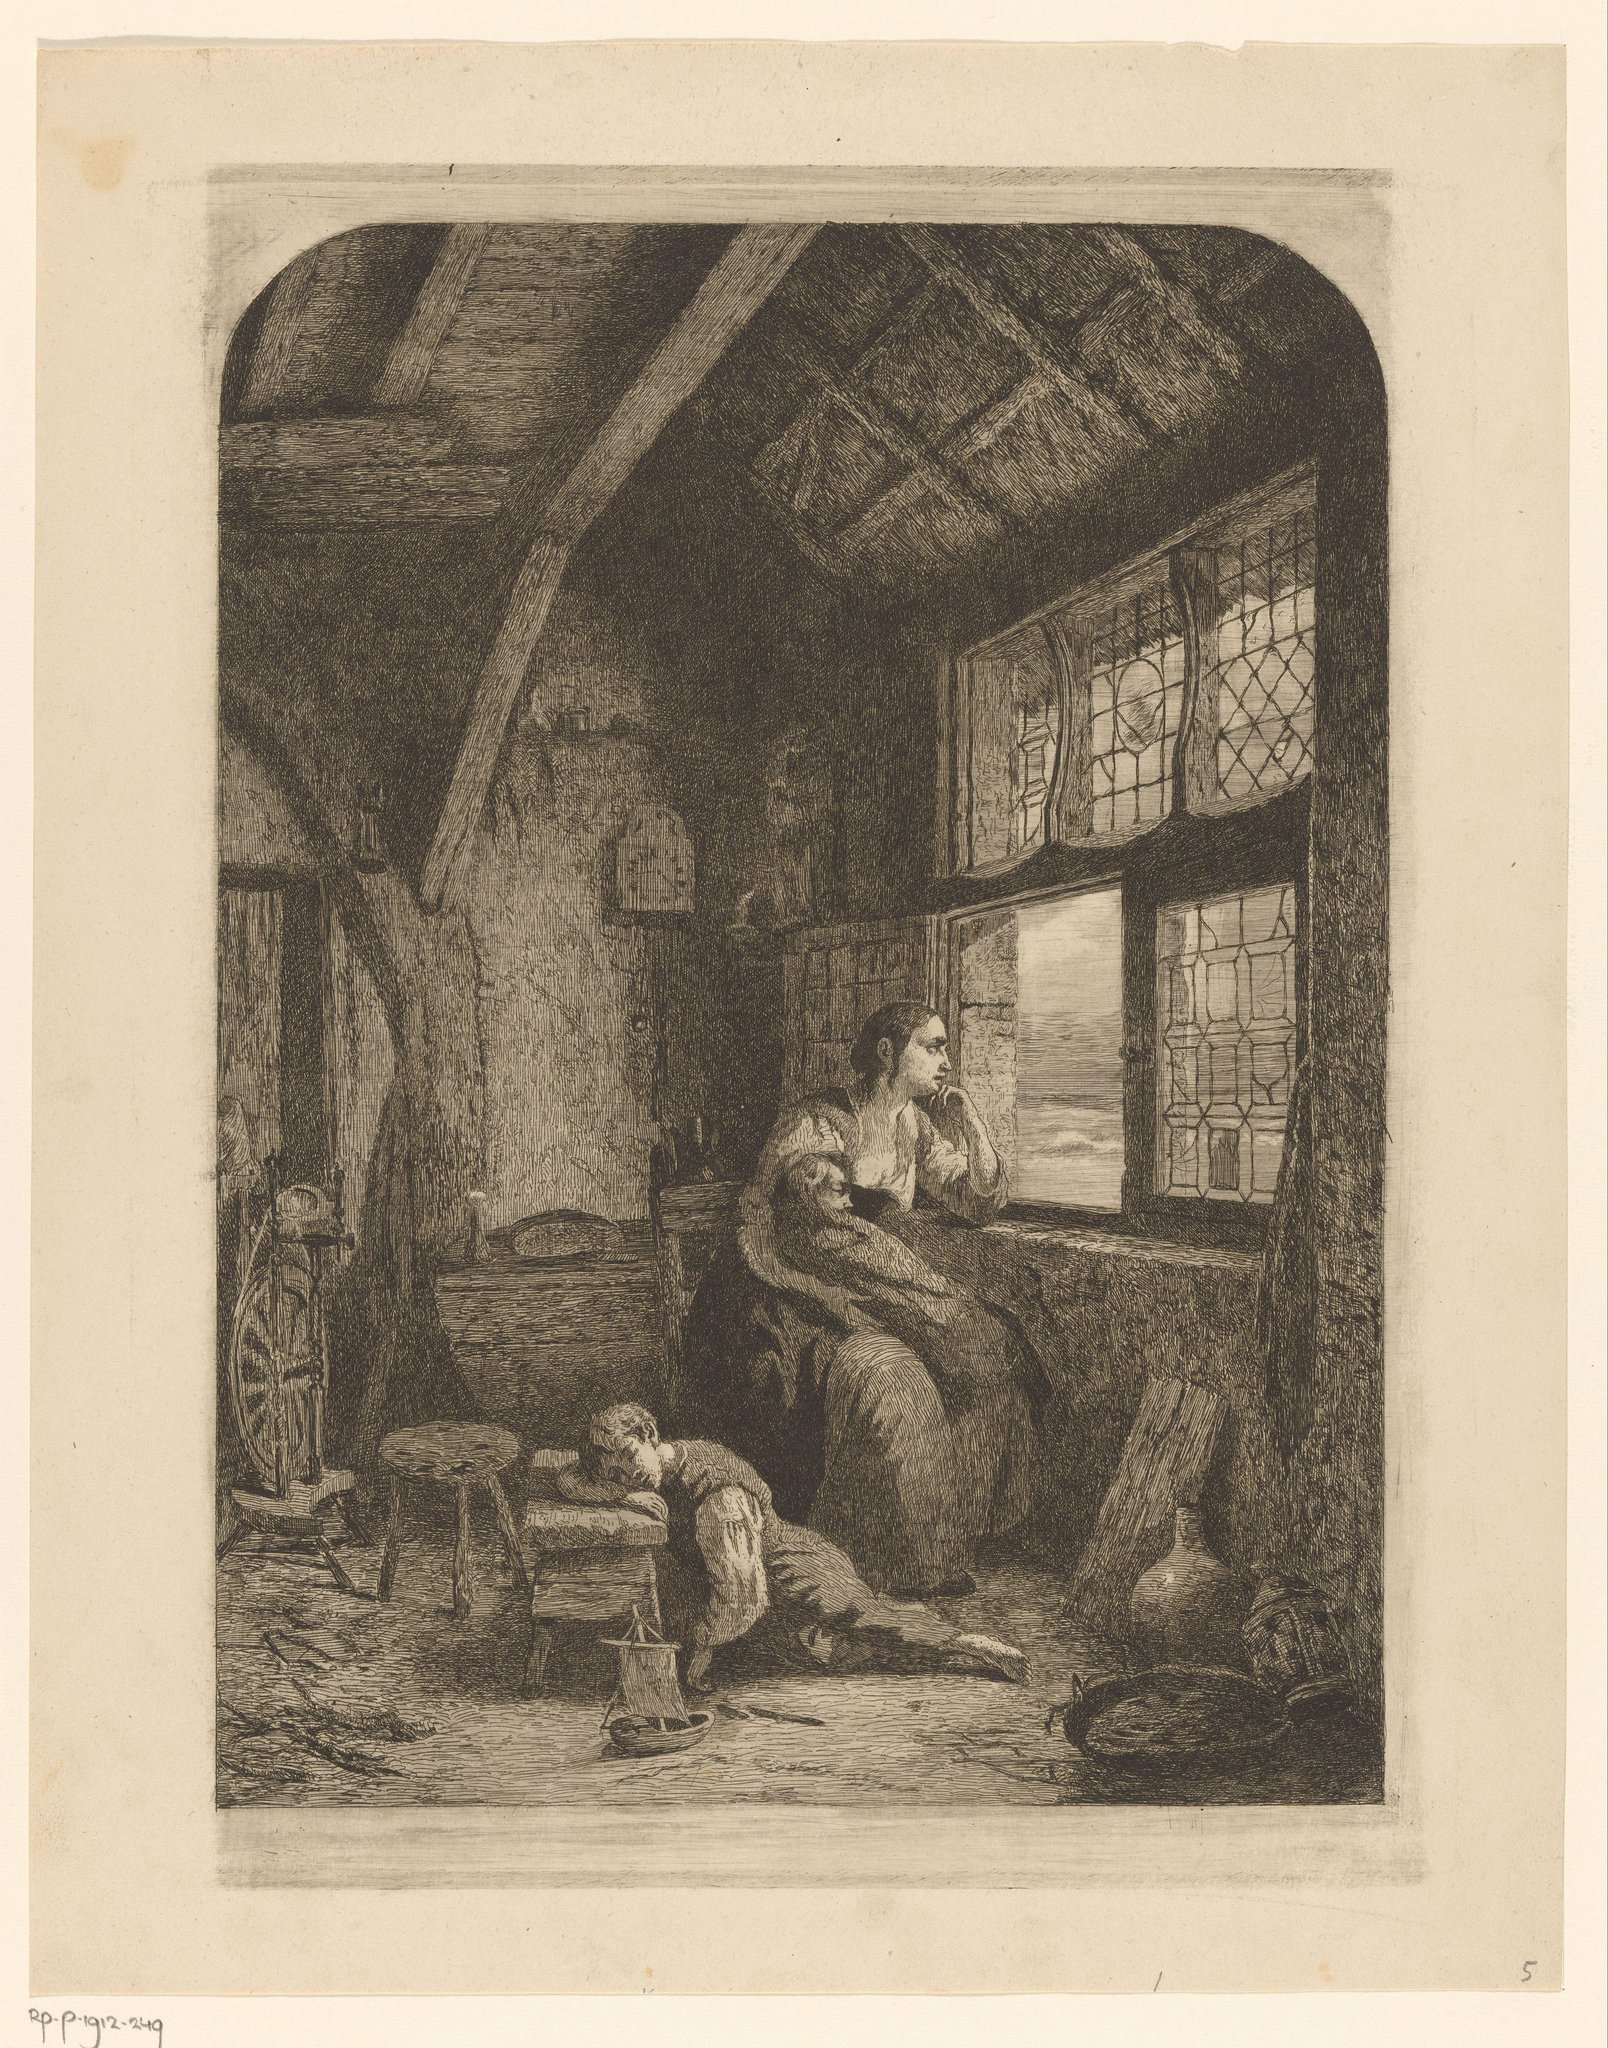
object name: print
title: Vrouw met twee slapende kinderen wachtend bij een open raam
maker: willem linnig (i)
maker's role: print maker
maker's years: 1819-1885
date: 1856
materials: paper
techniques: etching, intaglio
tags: mother and child(ren), woman and child(ren) (family group)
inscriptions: annotation: ‘5me état / il existe 2 exemplaires de cet état’, collector's mark: Lugt 1485, collector's mark: Lugt 2228